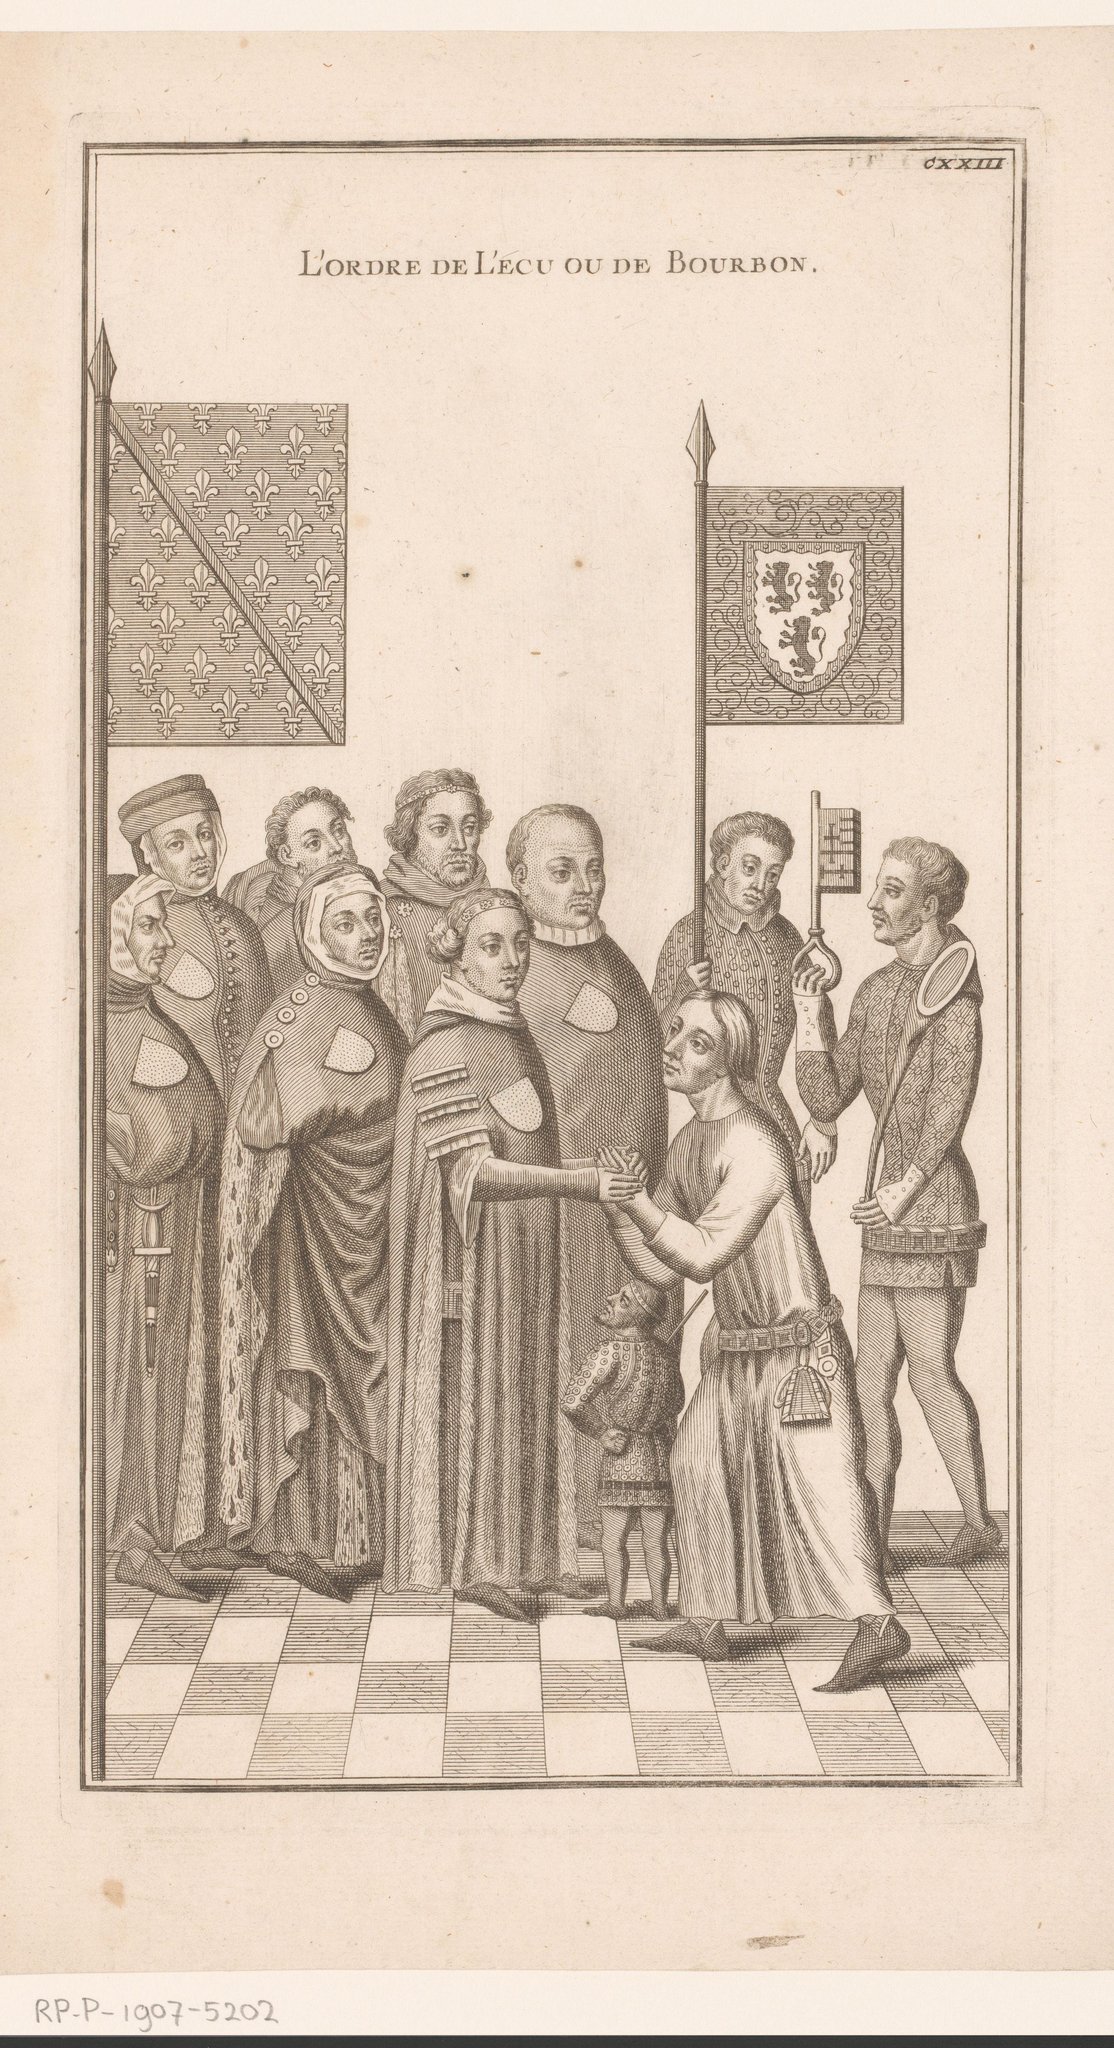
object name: book illustration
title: Leden van de orde van het Gouden Schild en hertog Lodewijk II van Bourbon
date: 1729-1733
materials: paper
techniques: engraving, etching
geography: paris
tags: knighthood order, historical persons, nobility and patriciate; chivalry, knighthood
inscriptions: collector's mark: Lugt 2228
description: Prent uit: Montfaucon, Bernard de. Les monumens de la monarchie françoise, qui comprennent l'histoire de France avec les figures de chaque règne que l'injure des tems a épargnées (...). Parijs: Julien-Michel Gandouin en Pierre-François Giffart, 1729-1733, dl. 3, afb. voor p. 23.